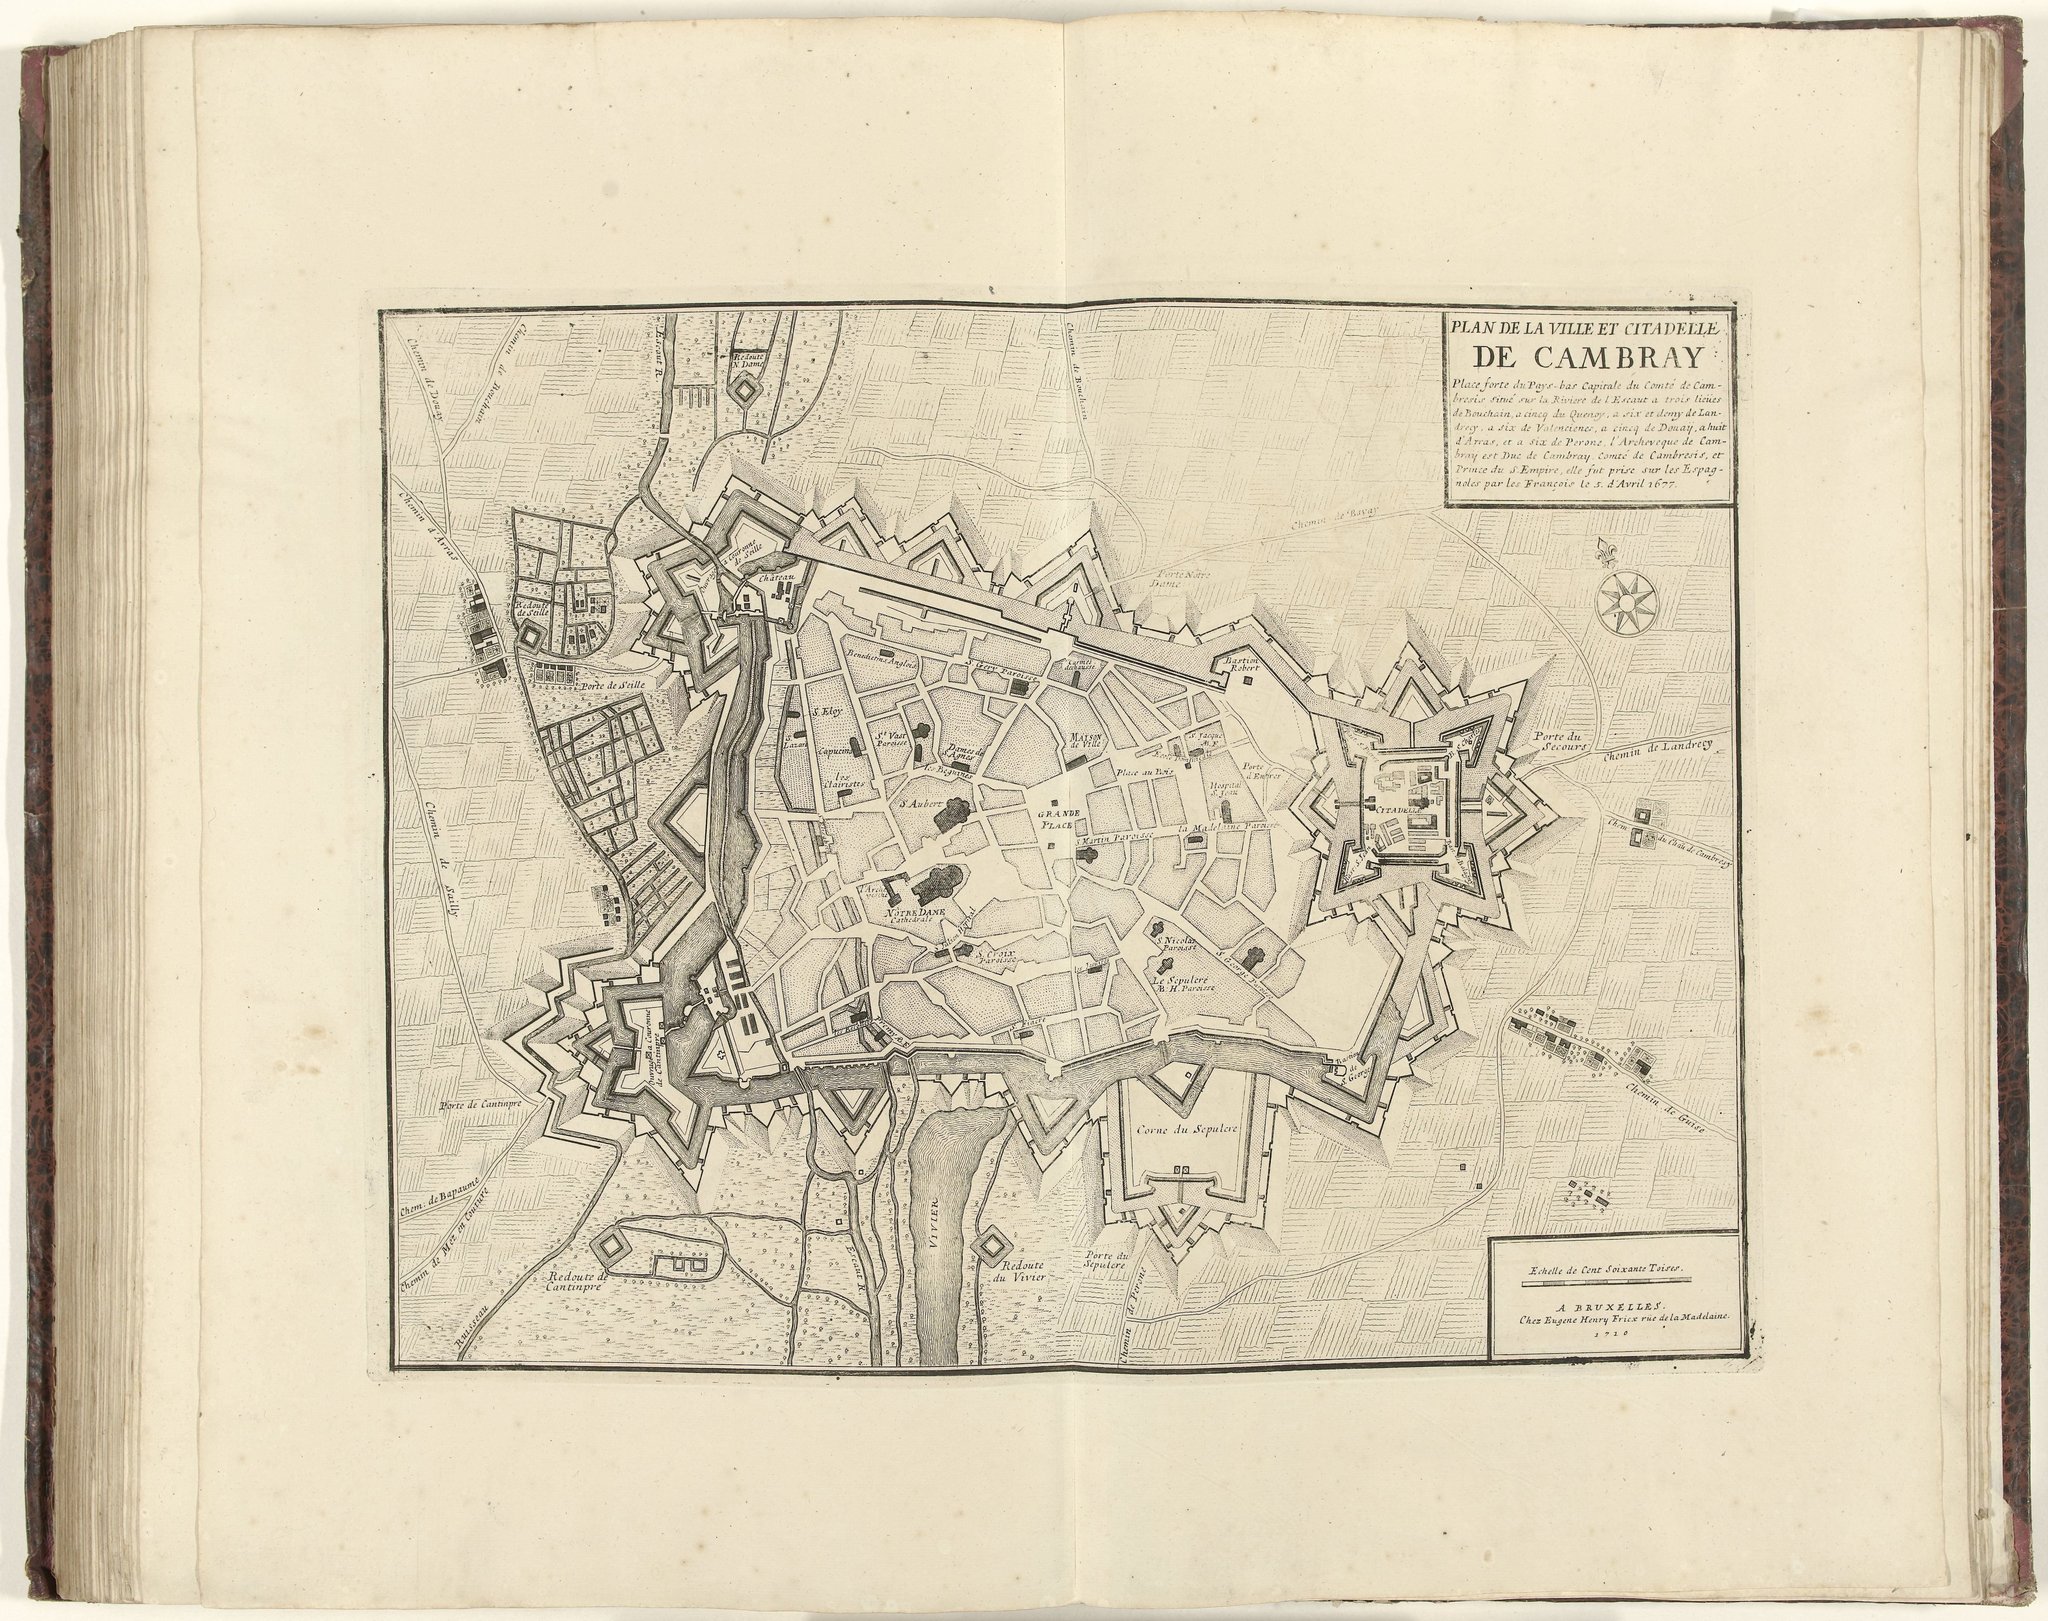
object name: print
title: Plattegrond van Cambrai, 1710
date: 1710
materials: paper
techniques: etching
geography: brussels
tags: maps of cities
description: Plattegrond van Cambrai, 1710. Rechtsonder de legenda A-P. Onderdeel van een gebundelde verzameling van plannen van veldslagen en steden vermaard in de Spaanse Successieoorlog.